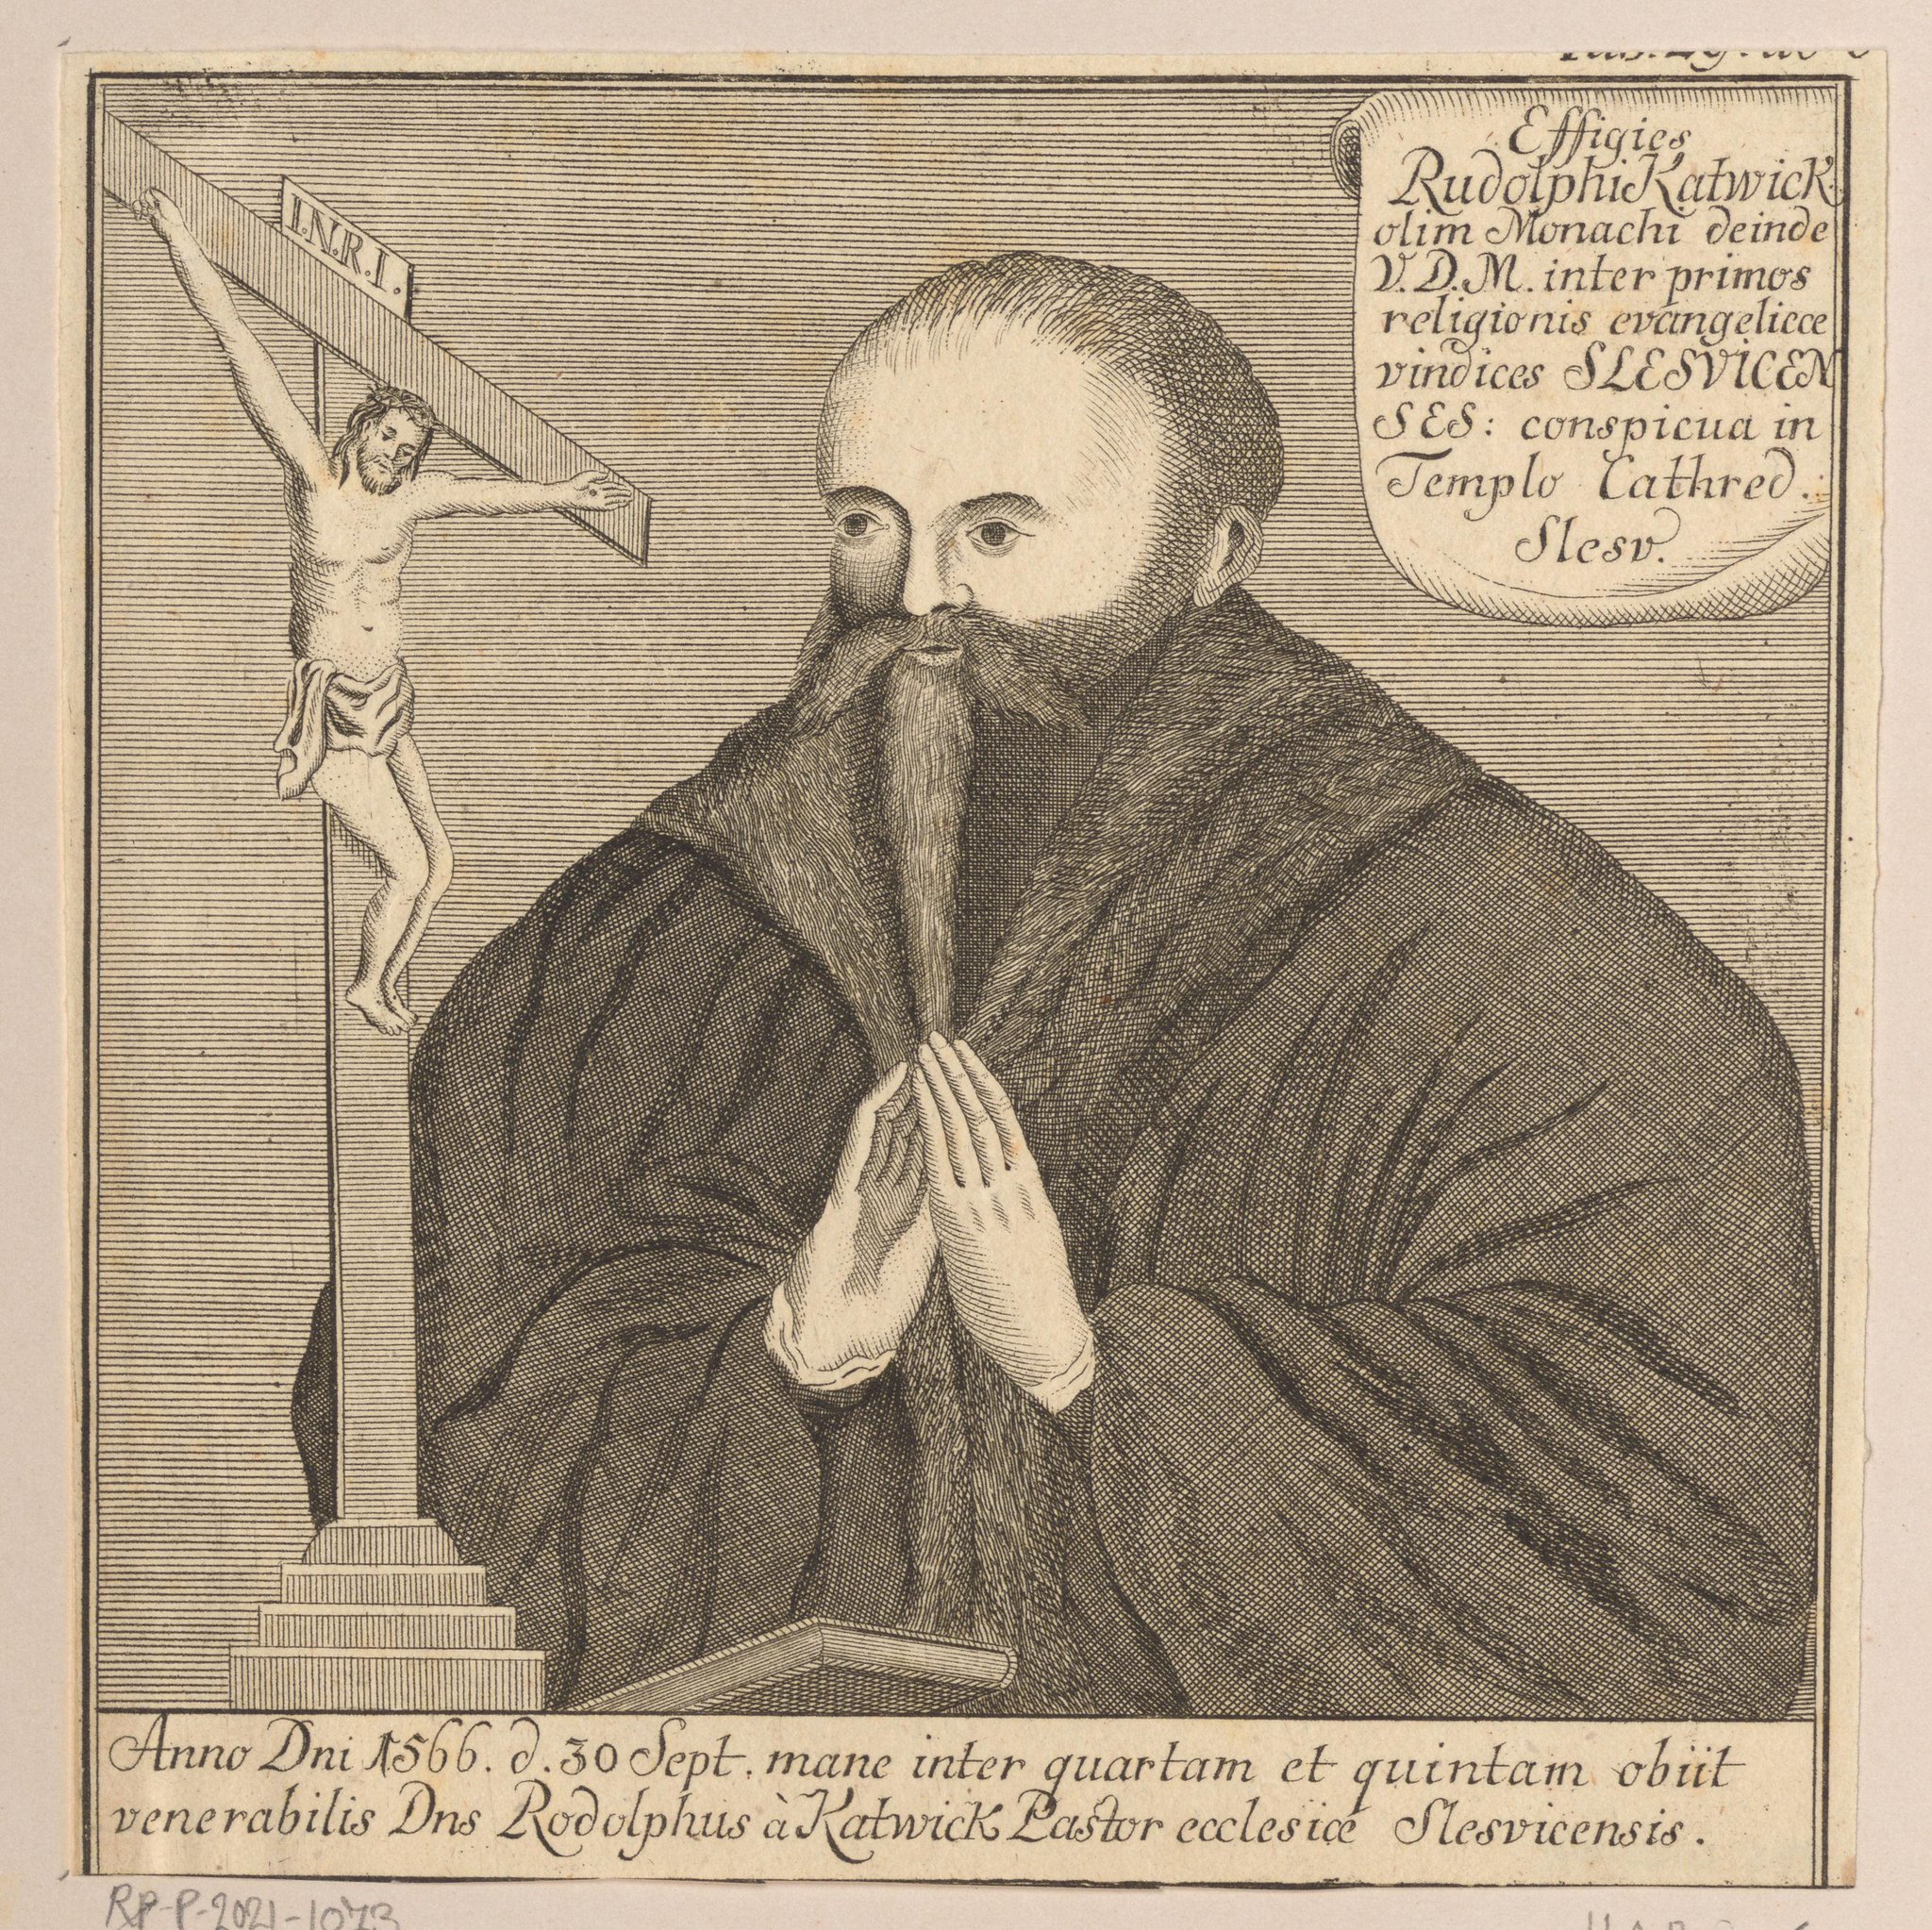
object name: print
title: Portret van Rudolph Katwick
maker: johann christian martini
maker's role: publisher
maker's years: -1752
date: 1745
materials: paper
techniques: engraving, etching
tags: priest, theologian, historical persons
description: Prent mogelijk uit: Monumenta inedita rerum Germanicarum (...). Leipzig: Johann Christian Martini, 1745, dl. 4.